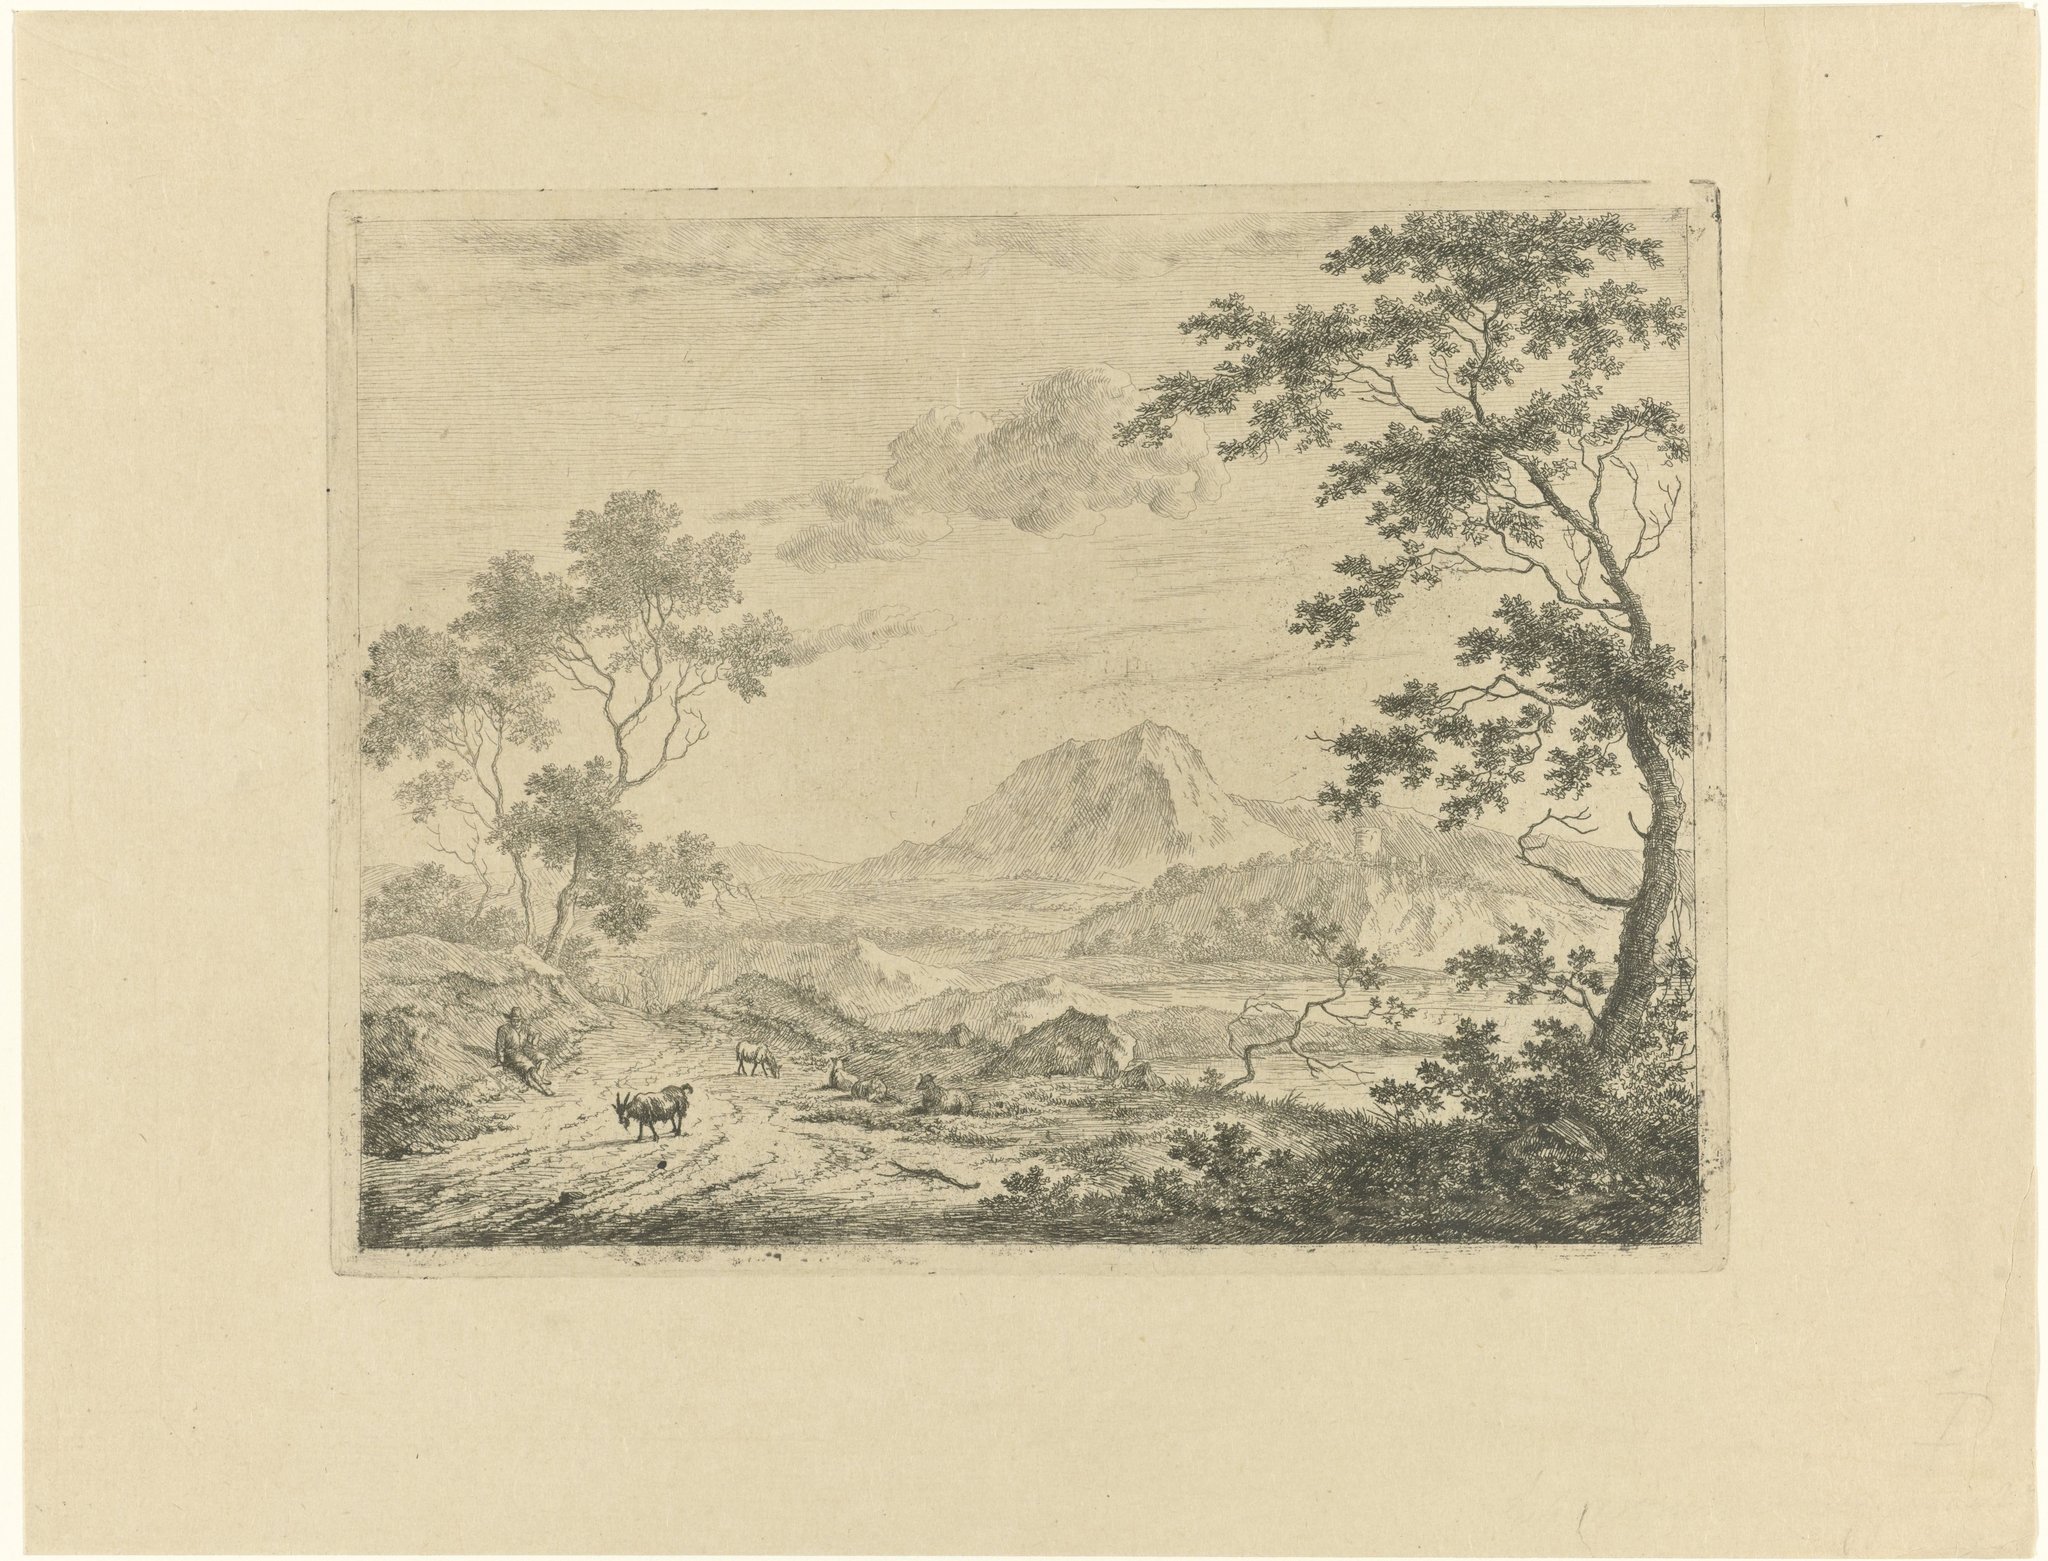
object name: print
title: Bergachtig landschap met rustende herder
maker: johannes janson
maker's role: draughtsman, painter, print maker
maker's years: 1729-1784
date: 1761-1784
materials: paper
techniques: etching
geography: leiden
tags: landscapes (+ landscape with figures, staffage)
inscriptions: collector's mark: Lugt 2228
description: Bergachtig landschap met links een rustende herder met schapen en een bok. Rechts een meer. Prent uit een serie met landschappen met herders en vee.